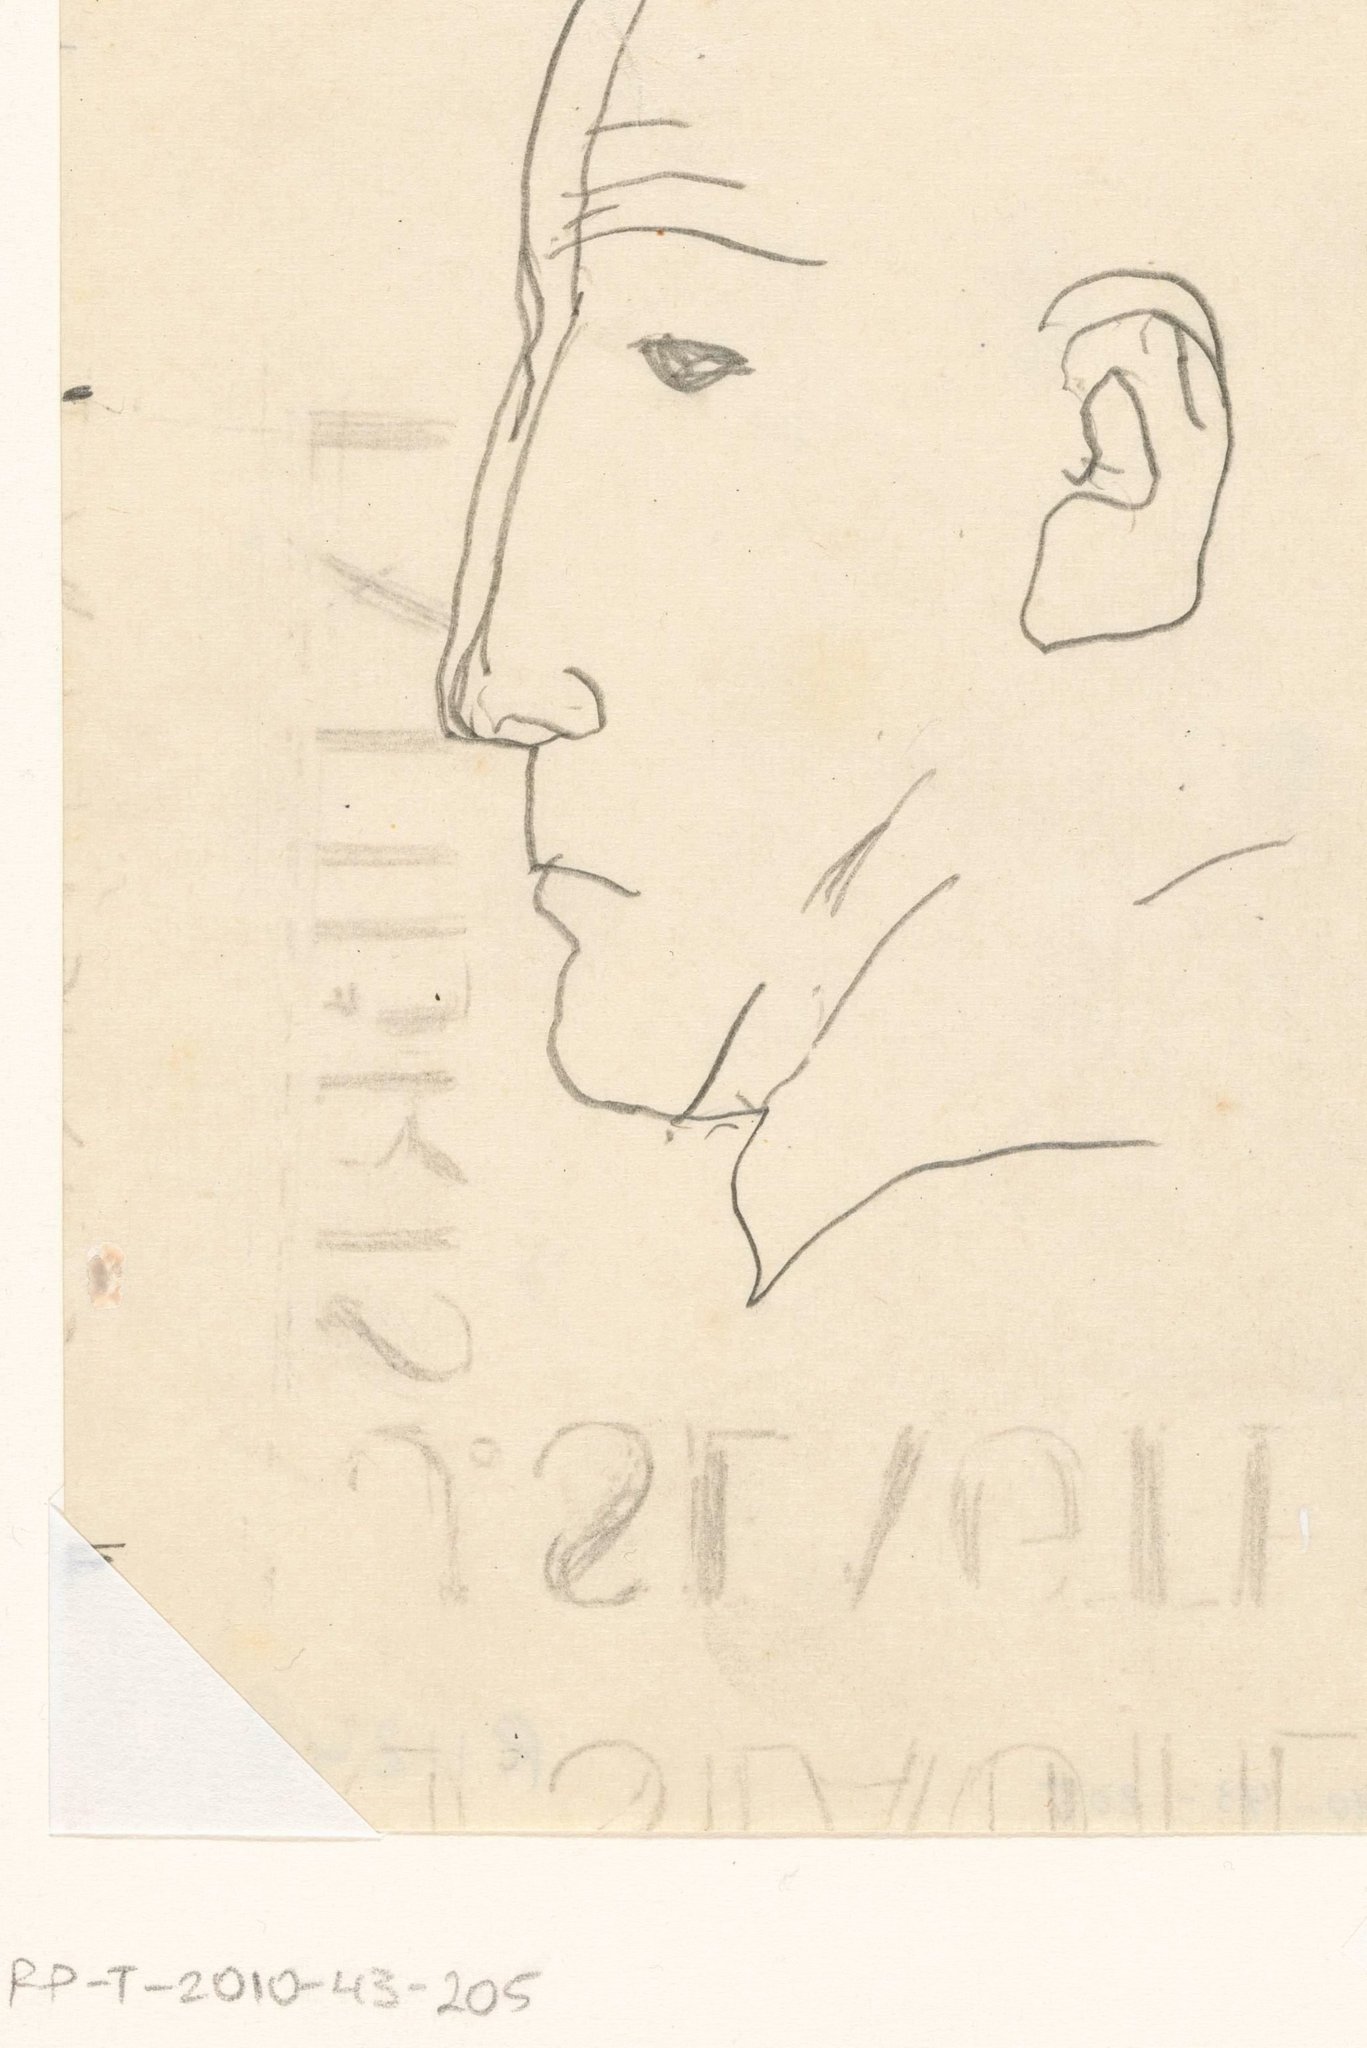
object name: drawing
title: Ex libris voor J. Slagter (ontwerp)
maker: leo gestel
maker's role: draughtsman, print maker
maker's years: 1881-1941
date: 1935-1940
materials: paper, pencil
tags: j. slagter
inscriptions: title: ‘EX-LIBRIS // J.SLAGTER’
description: De huidige titels zijn door het museum toegekend bij gebrek aan informatie over een originele titel.